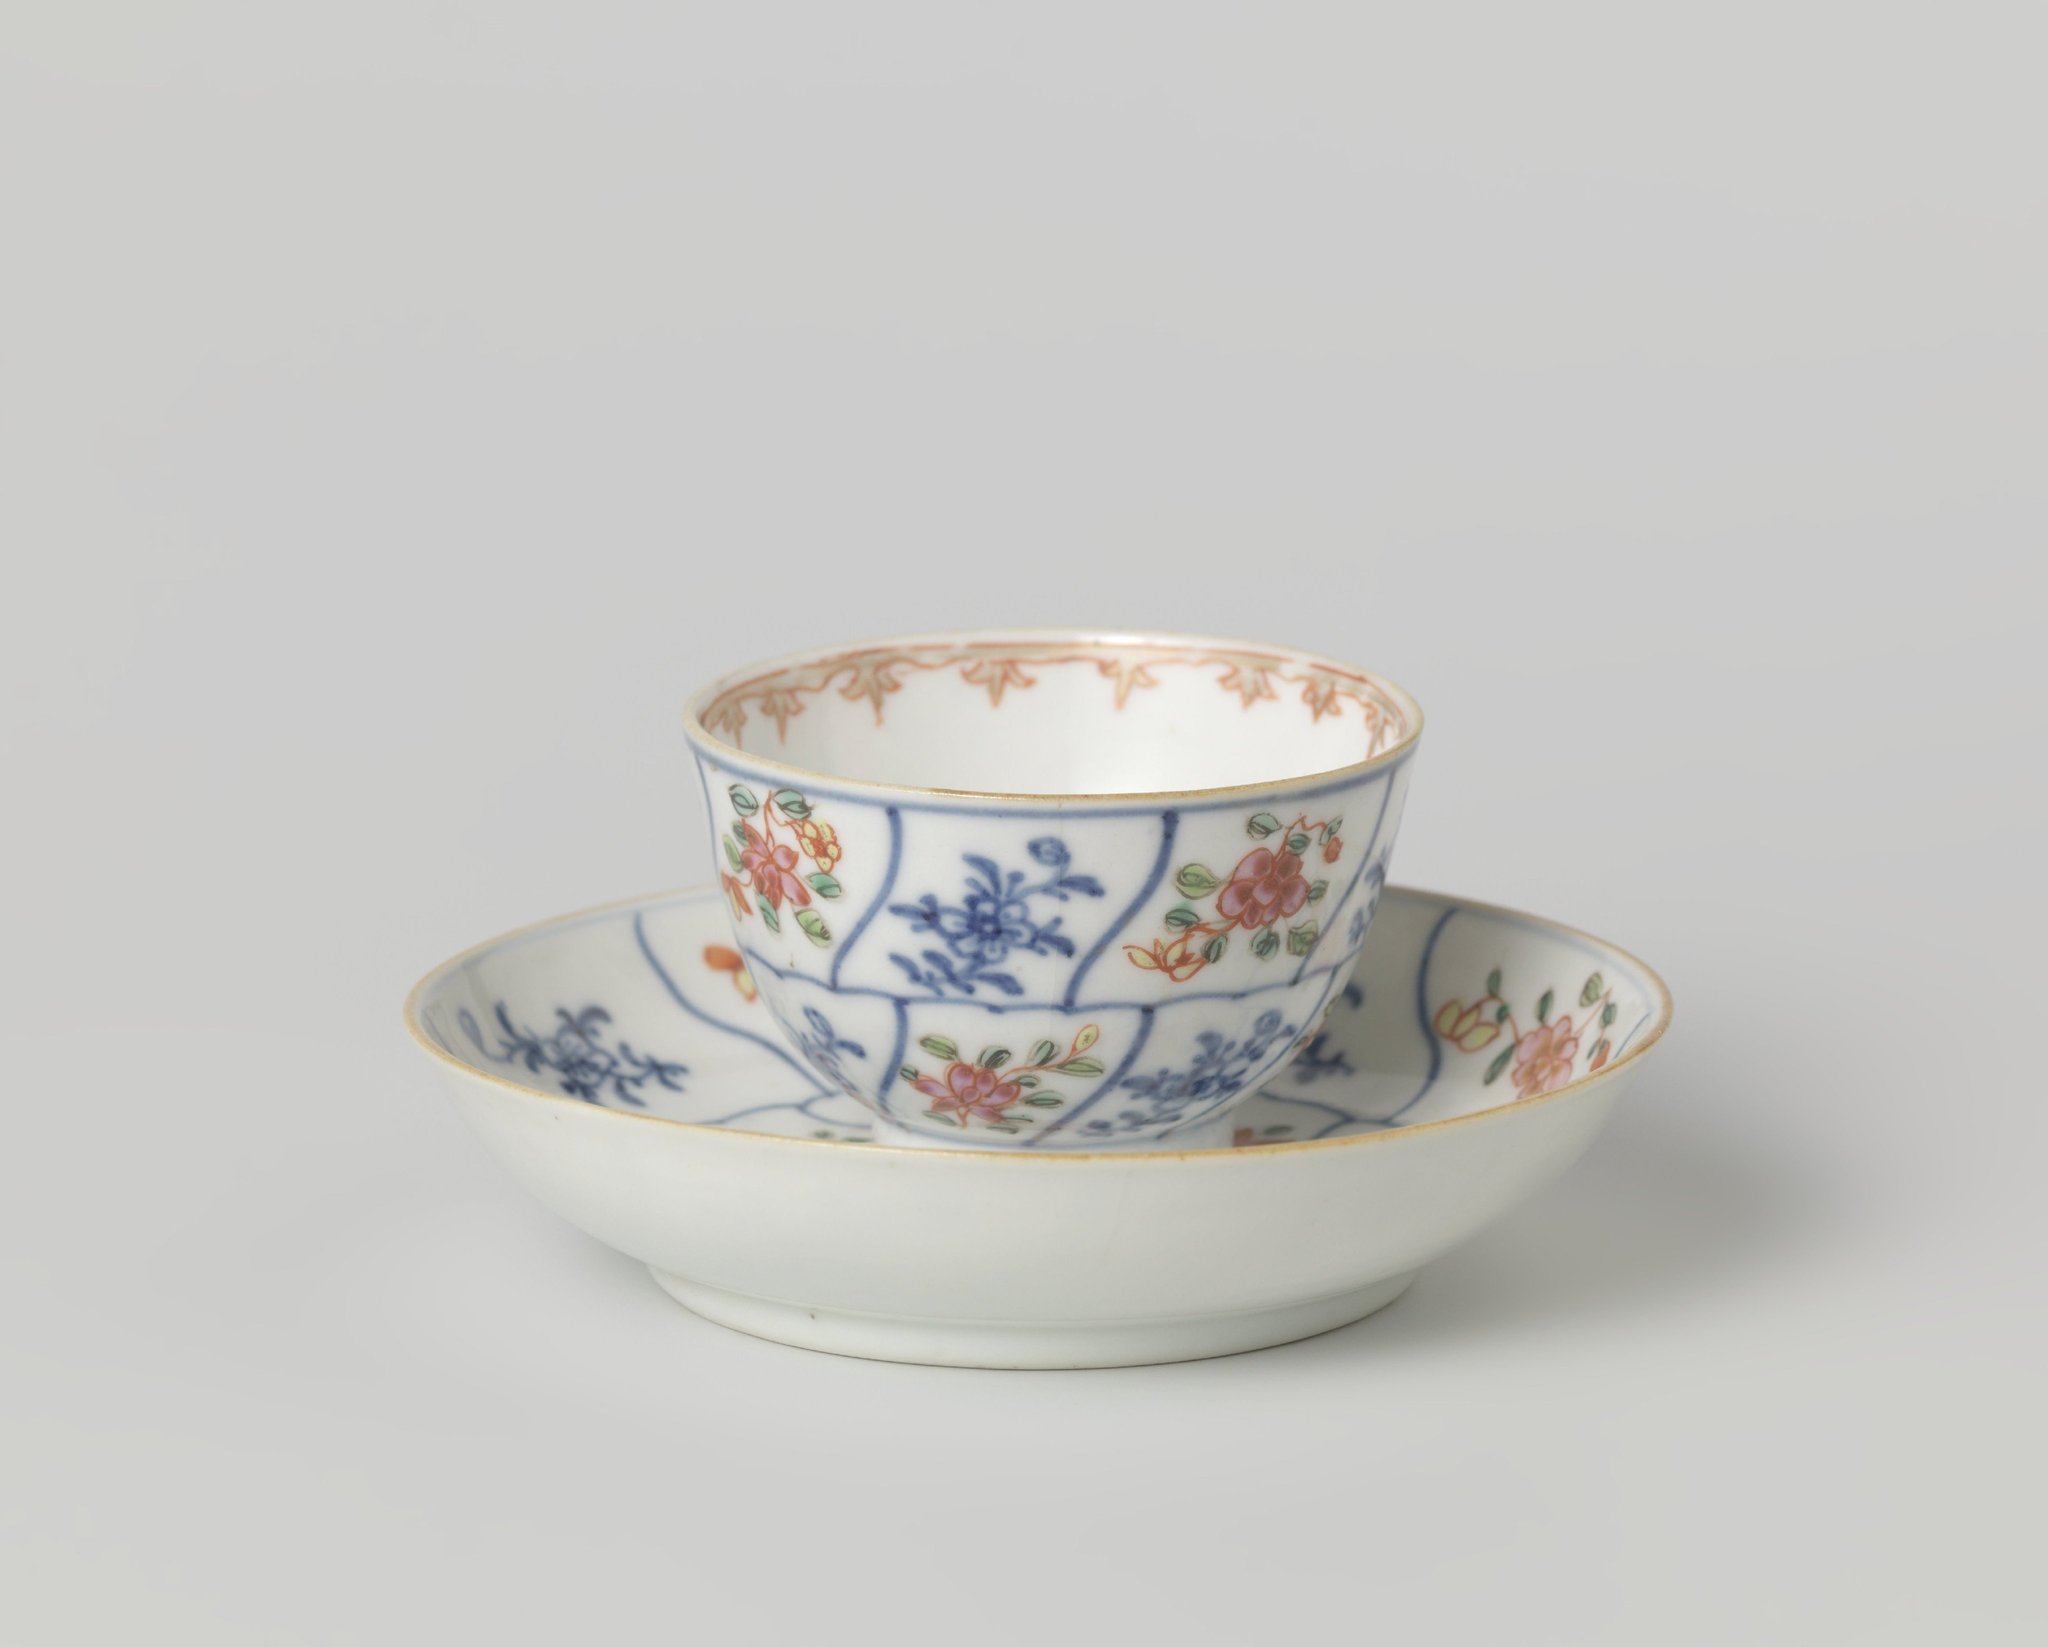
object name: kop en schotel, kop en schotel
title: Straight-sided cup and saucer with petal-shaped panels with flower sprays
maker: Anonymous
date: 1750-1774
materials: cobalt, glaze, gold, paint, porcelain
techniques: firing, gilding, turning, vitrification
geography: china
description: Kop en schotel van porselein met rechte wand, beschilderd in onderglazuur blauw en op het glazuur rood, roze, groen, geel, zwart en goud. Op het plat van de schotel een medaillon met bloemtak; hier omheen twee rijen met bloemtakken in bloembladvormige vakken. De kop met dezelfde decoratie met op de bodem een bloemtak en op de binnenrand een spearhead-border. Een barst in de wand van de kop. Famille rose.